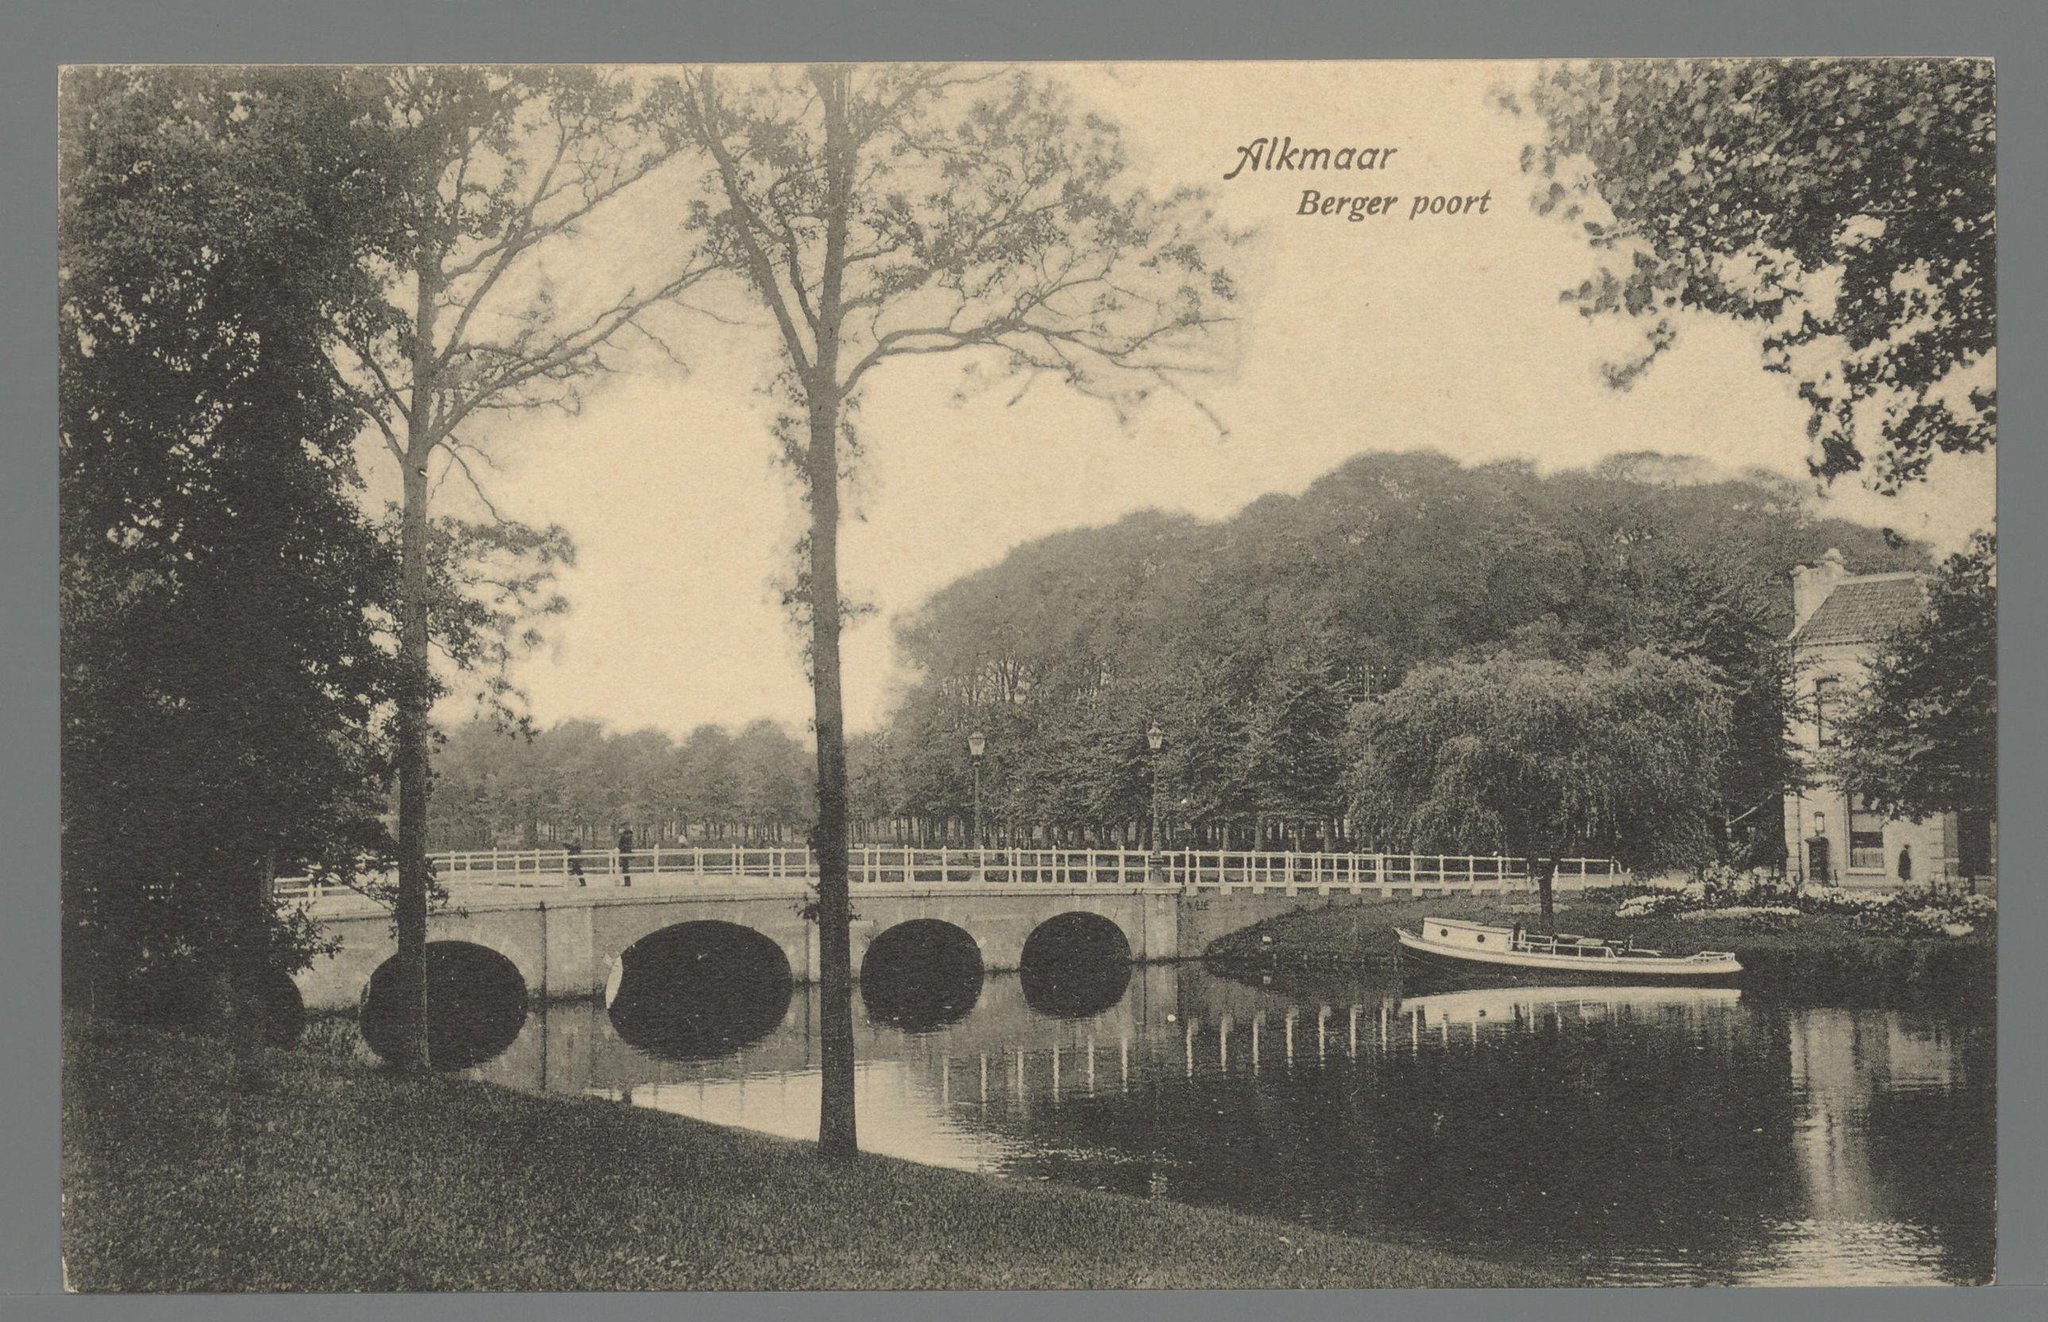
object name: ansichtkaart, prentbriefkaart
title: Alkmaar. Berger poort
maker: Anonymous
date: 1909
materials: cardboard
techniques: photograph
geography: the hague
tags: city-view, and landscape with man-made constructions, bridge in city across river, canal, etc.